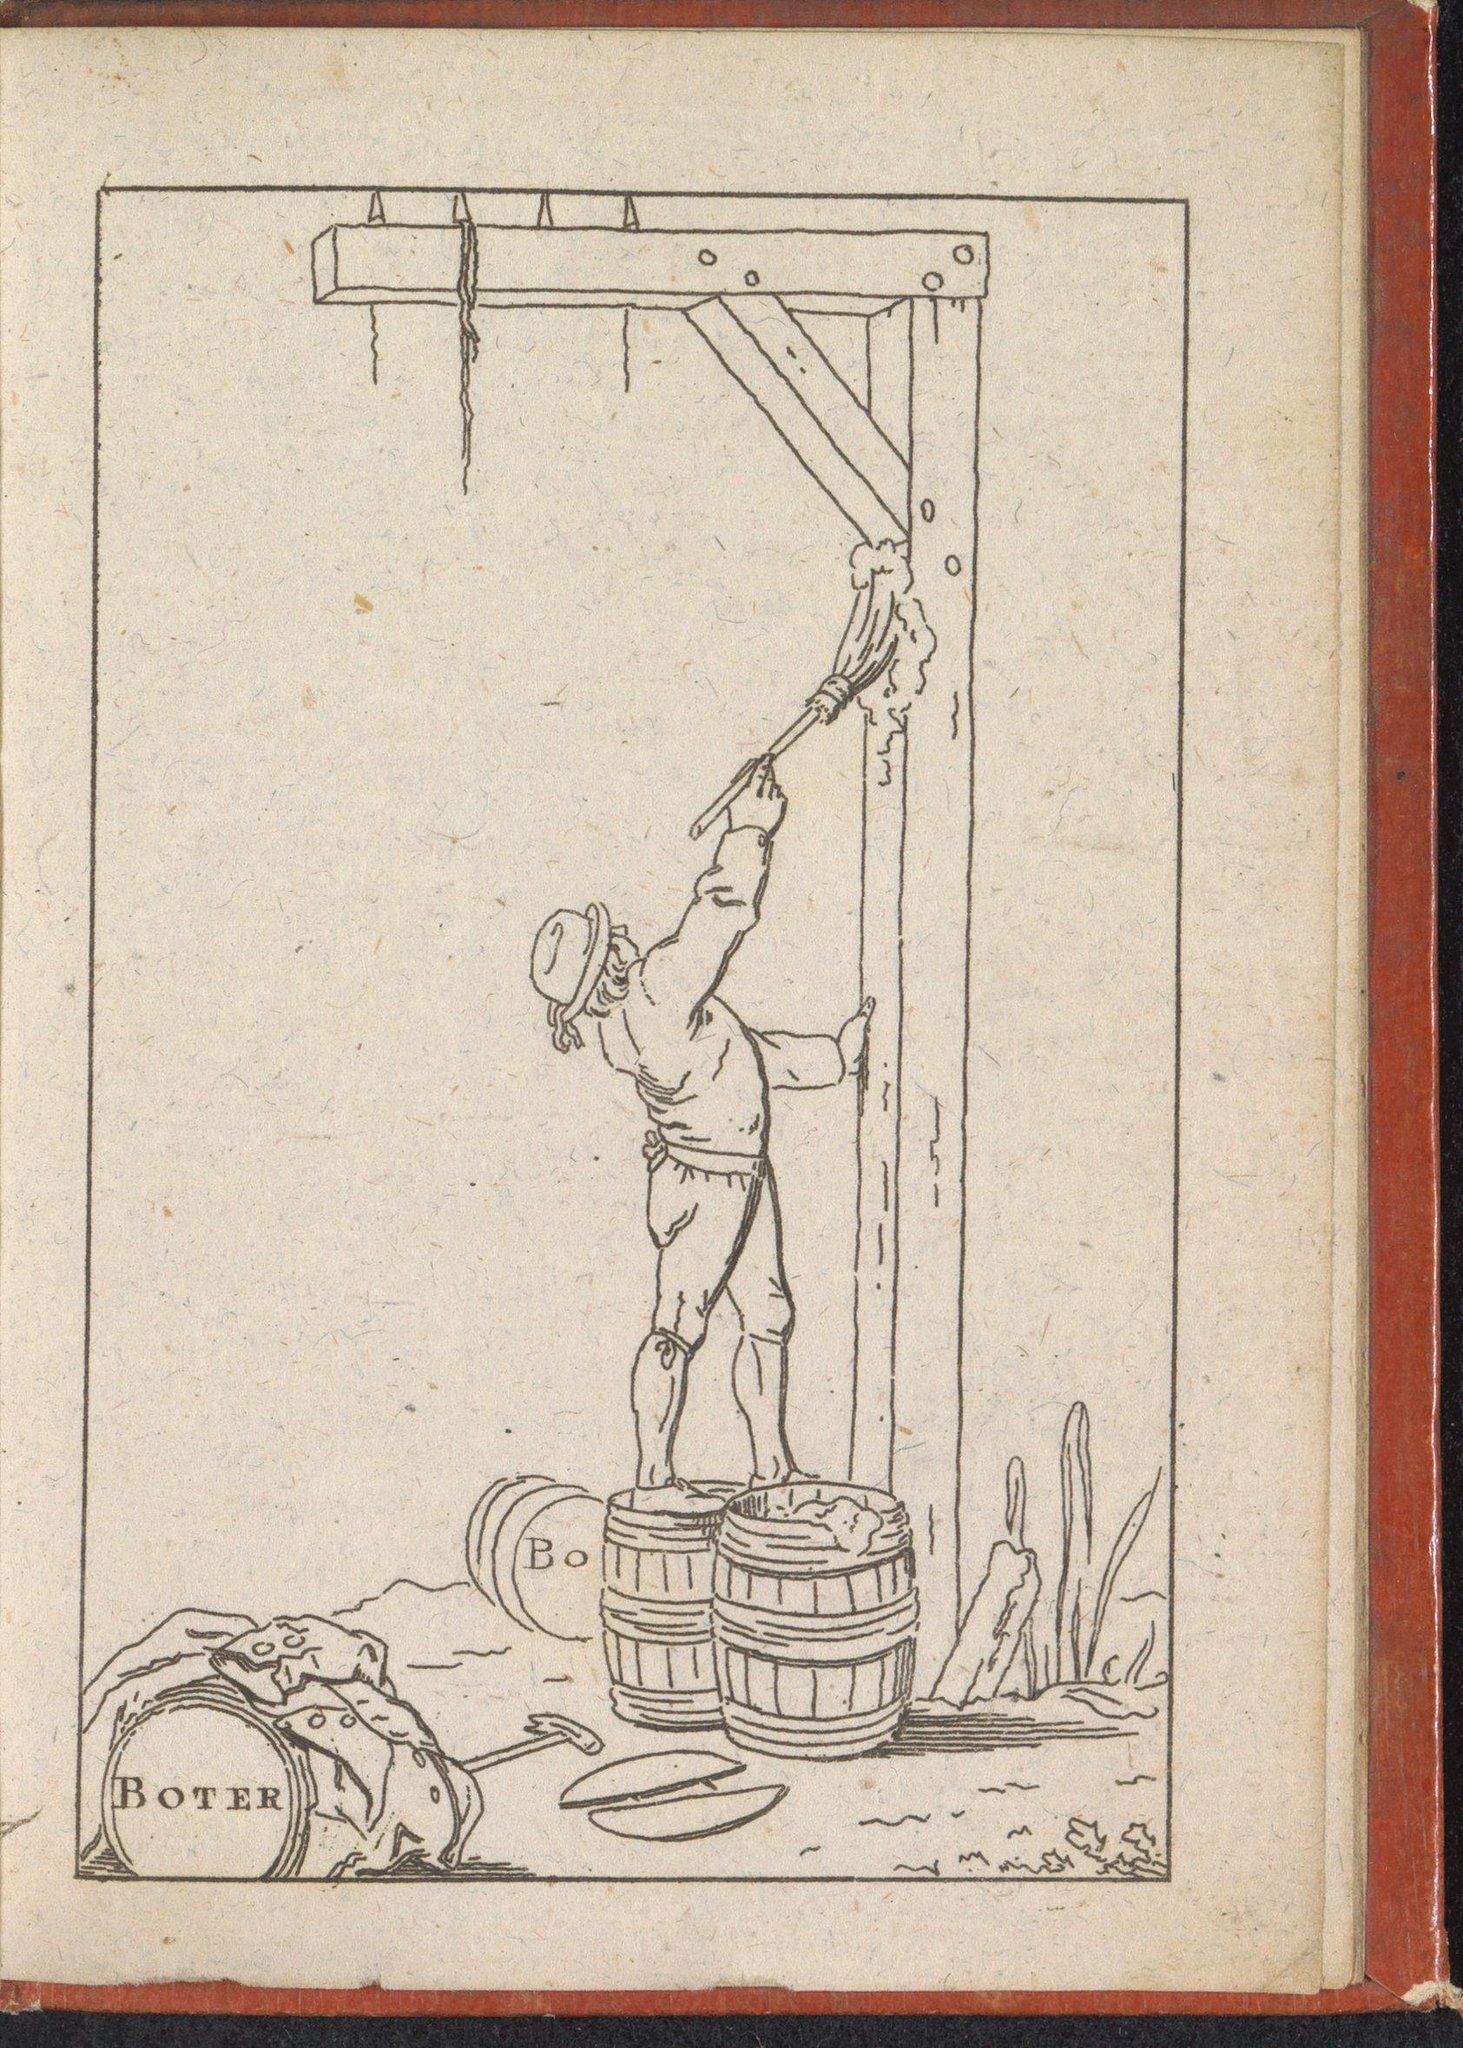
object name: print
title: Boter aan de galg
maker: pieter van woensel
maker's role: print maker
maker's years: 1747-1808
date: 1792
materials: paper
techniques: etching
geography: northern netherlands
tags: instruments of torture, execution or punishment: gallows, butter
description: Gebruikt als illustratie in: De Lantaarn voor 1792; in het exemplaar in de Rijksmuseum Research Library met signatuur: 305-G-1.